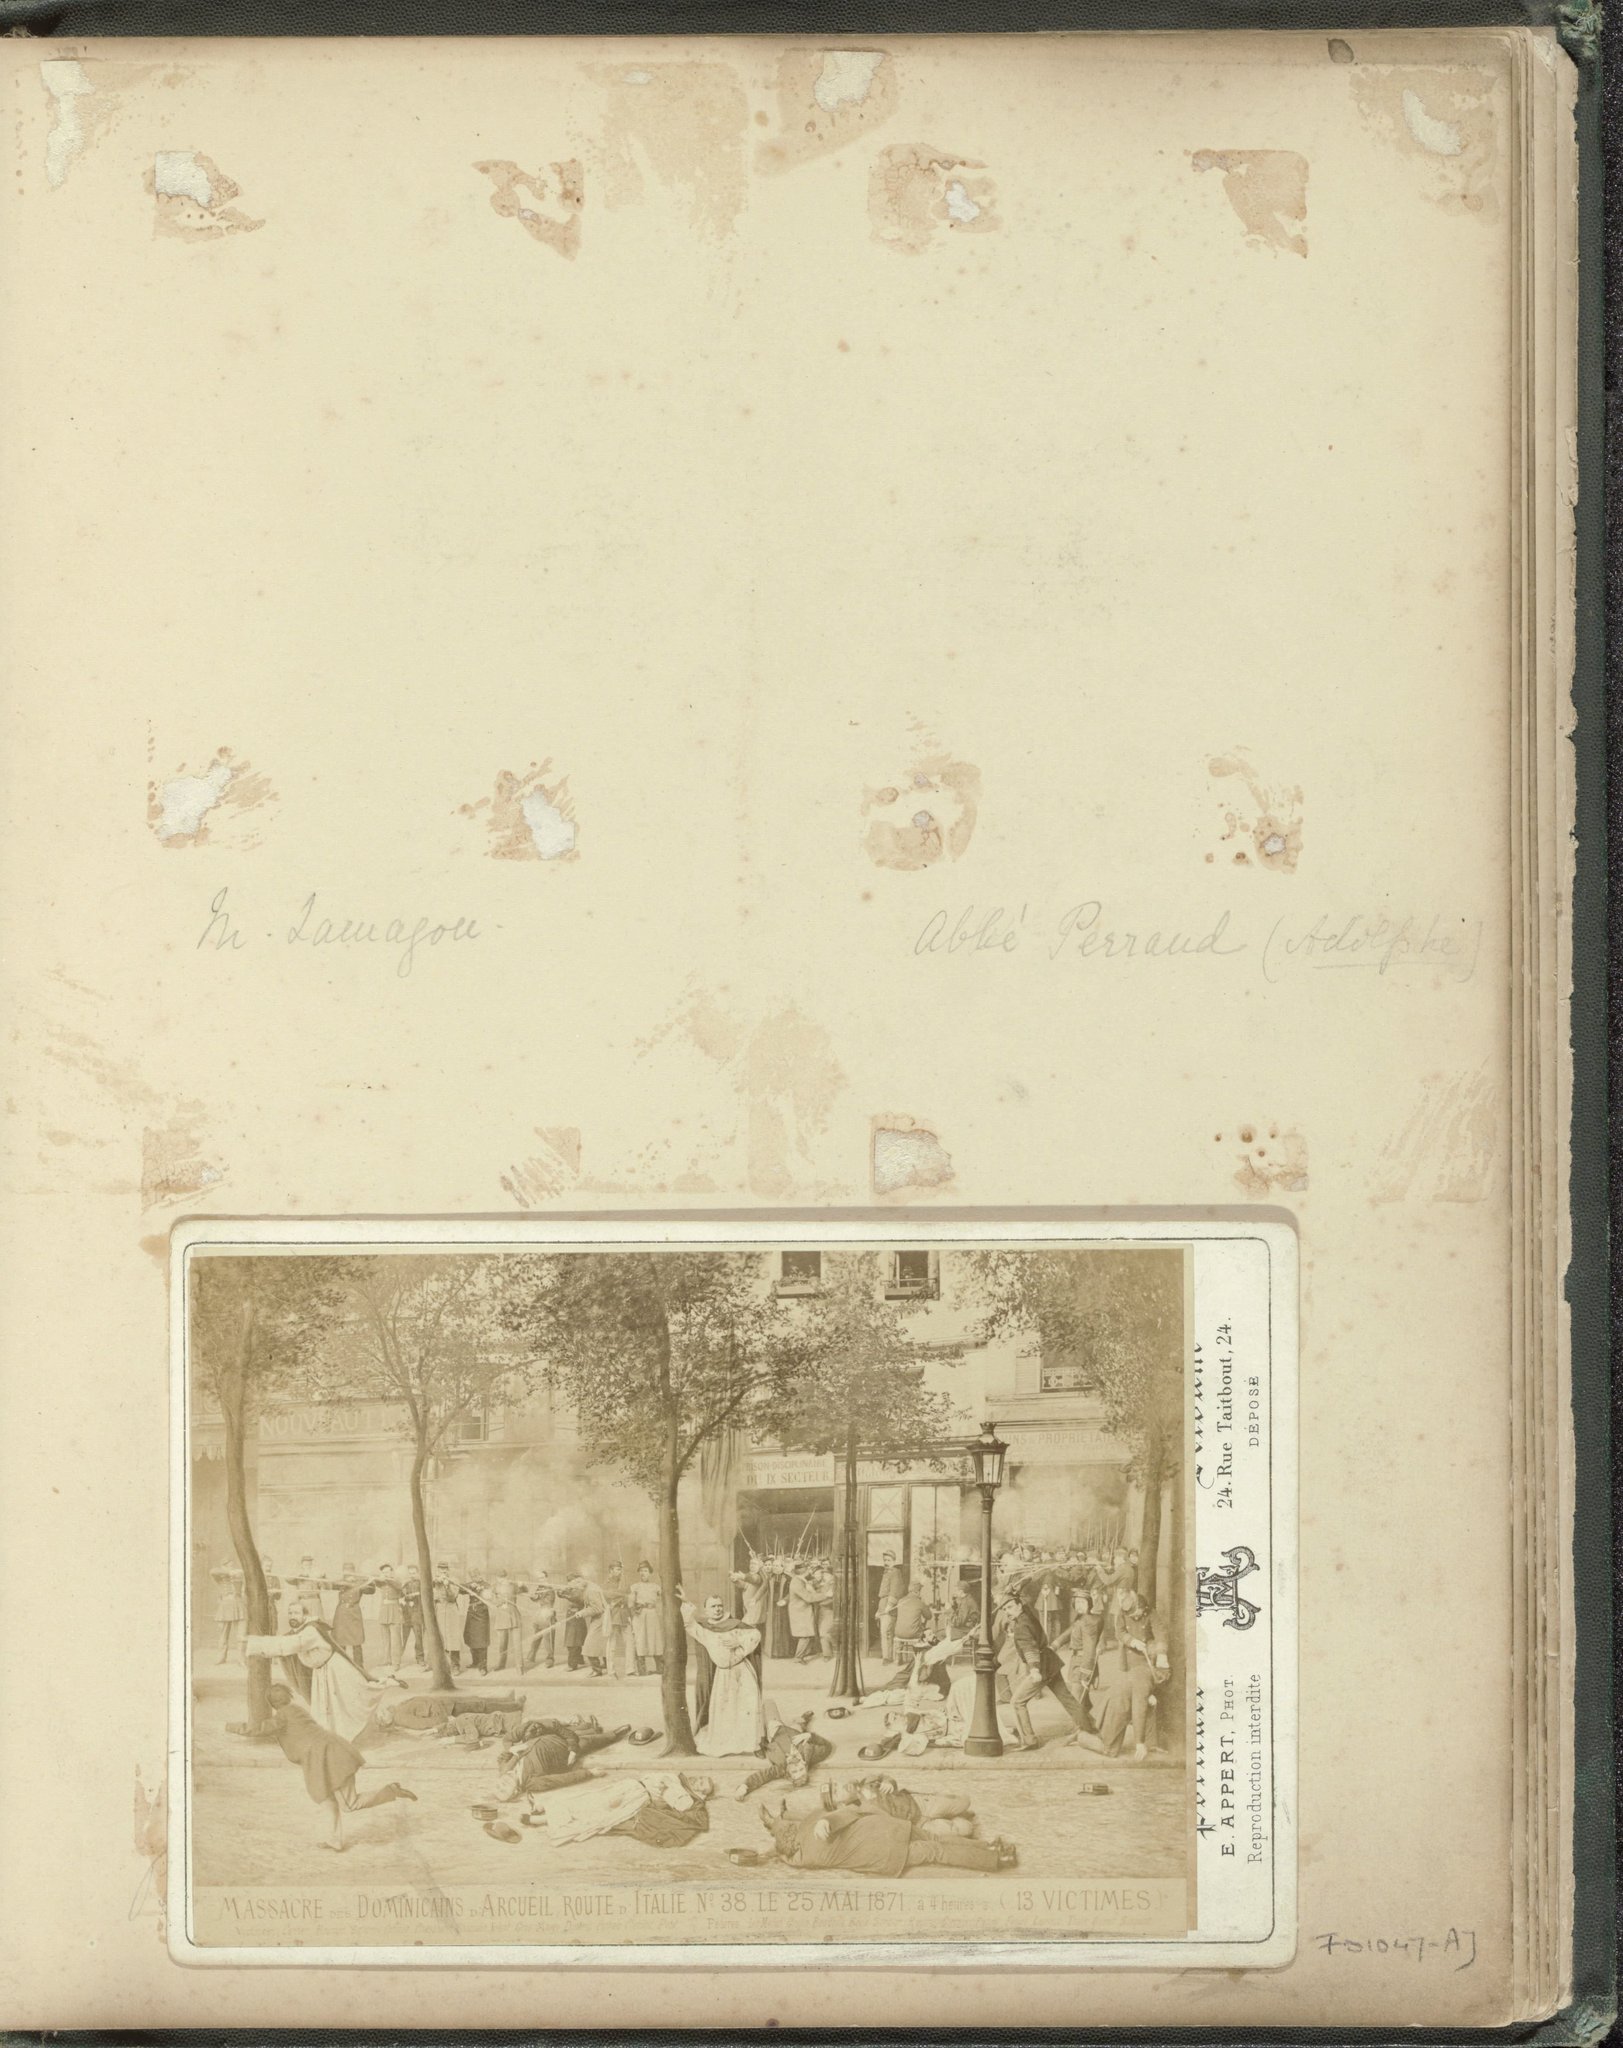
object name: photomontage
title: Fotomontage van de moordpartij op Dominicaner broeders aan de Route d'Italie in Parijs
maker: ernest eugène appert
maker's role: fotograaf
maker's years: 1830-1891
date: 1871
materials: cardboard, paper, photographic support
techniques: albumen print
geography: paris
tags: death penalty, execution, violent death, being killed; being mishandled and maltreated; seeking death - ee - death not certain; wounded person, paris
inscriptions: address: ‘24, Rue Taitbout, 24’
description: Onderdeel van Herdenkingsalbum van rooms-katholieke geestelijken gevallen tijdens de Commune van Parijs.